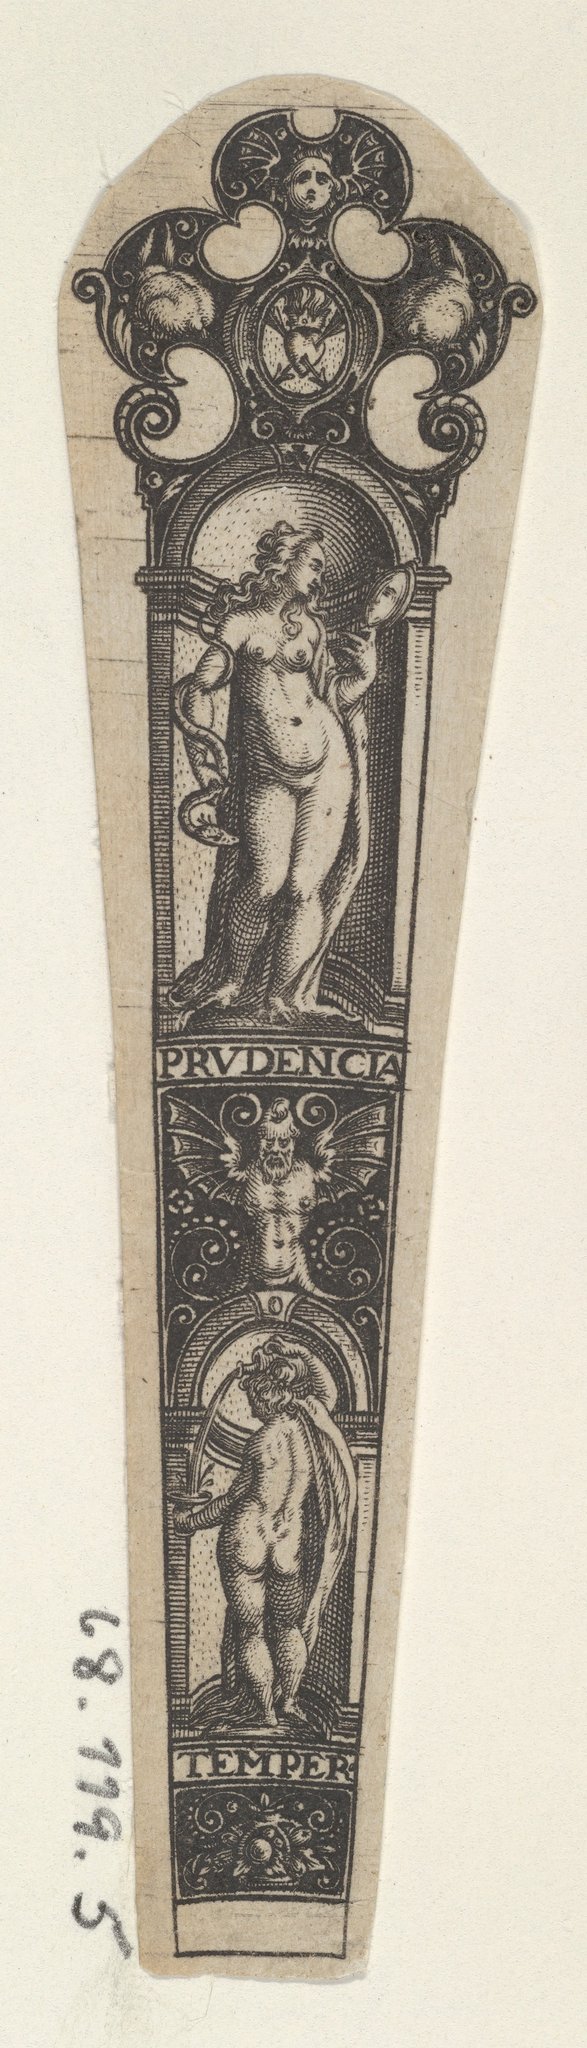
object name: print ornament architecture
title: Design for a Knife Handle with Personifications of Prudence and Temperance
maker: johann theodor de bry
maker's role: artist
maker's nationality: netherlandish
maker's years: 1561-1623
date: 1580-1600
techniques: embroidery, engraving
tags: knives,ornament,female nudes